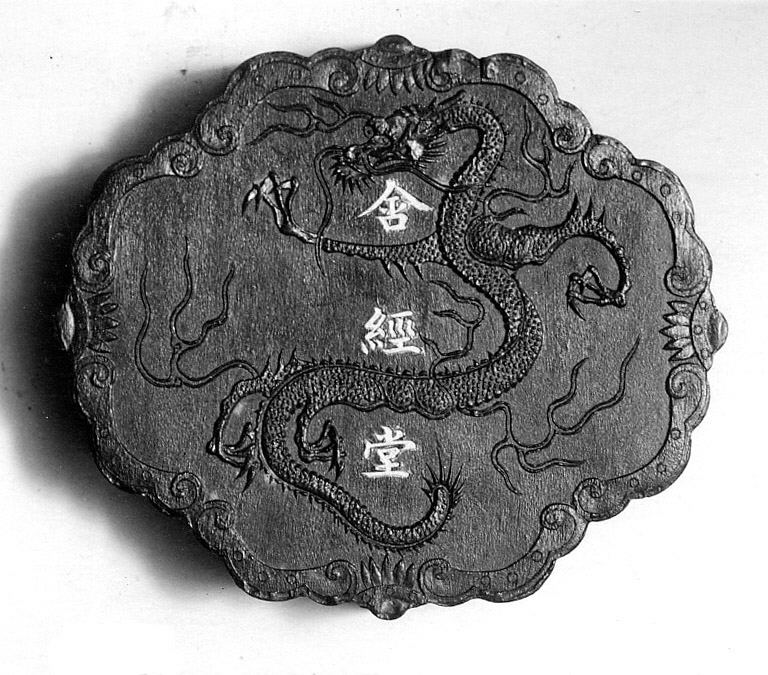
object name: ink tablet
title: Holding the Classics Hall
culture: chinese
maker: jian guzhai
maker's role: artist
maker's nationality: chinese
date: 1867-1933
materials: ink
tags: dragons